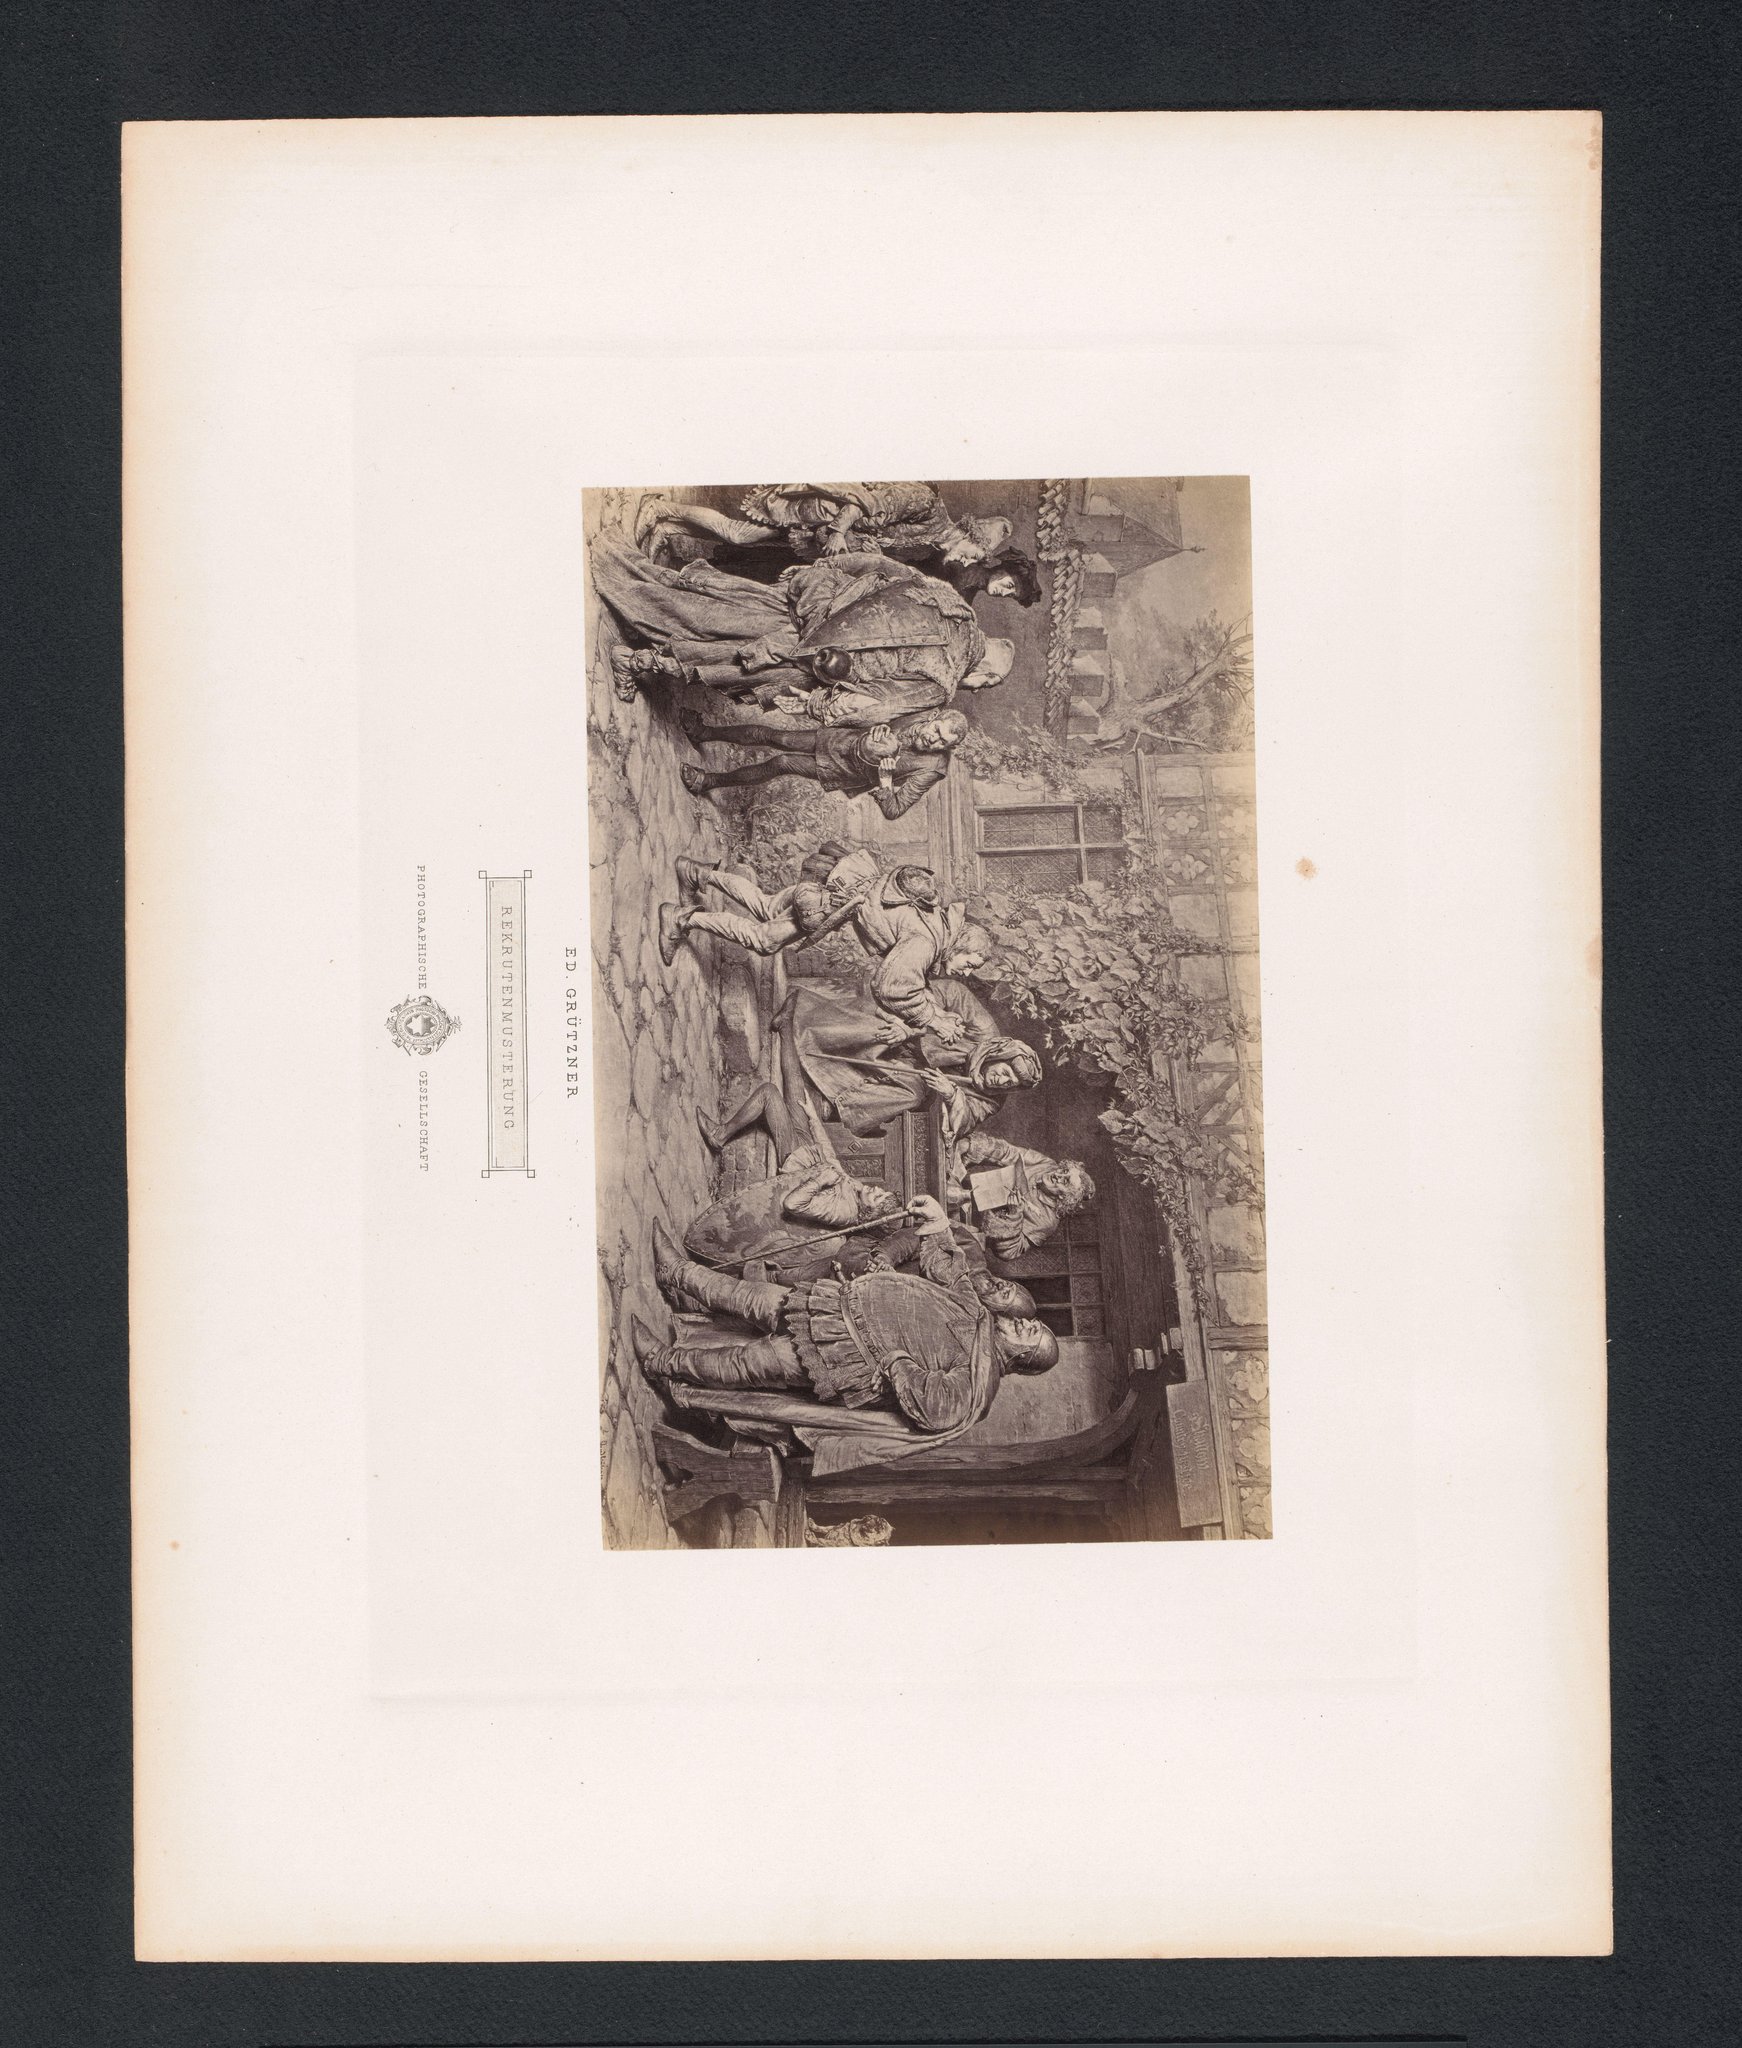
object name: reproduction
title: Fotoreproductie van Rekrutenmusterung door Eduard von Grützner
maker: eduard von grützner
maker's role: painter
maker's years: 1846-1925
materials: photographic support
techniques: albumen print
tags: recruitment, specific works of literature, falstaff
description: Deze foto maakt deel uit van een omslag met zeven foto's, een titelblad met foto en een tekstblad.